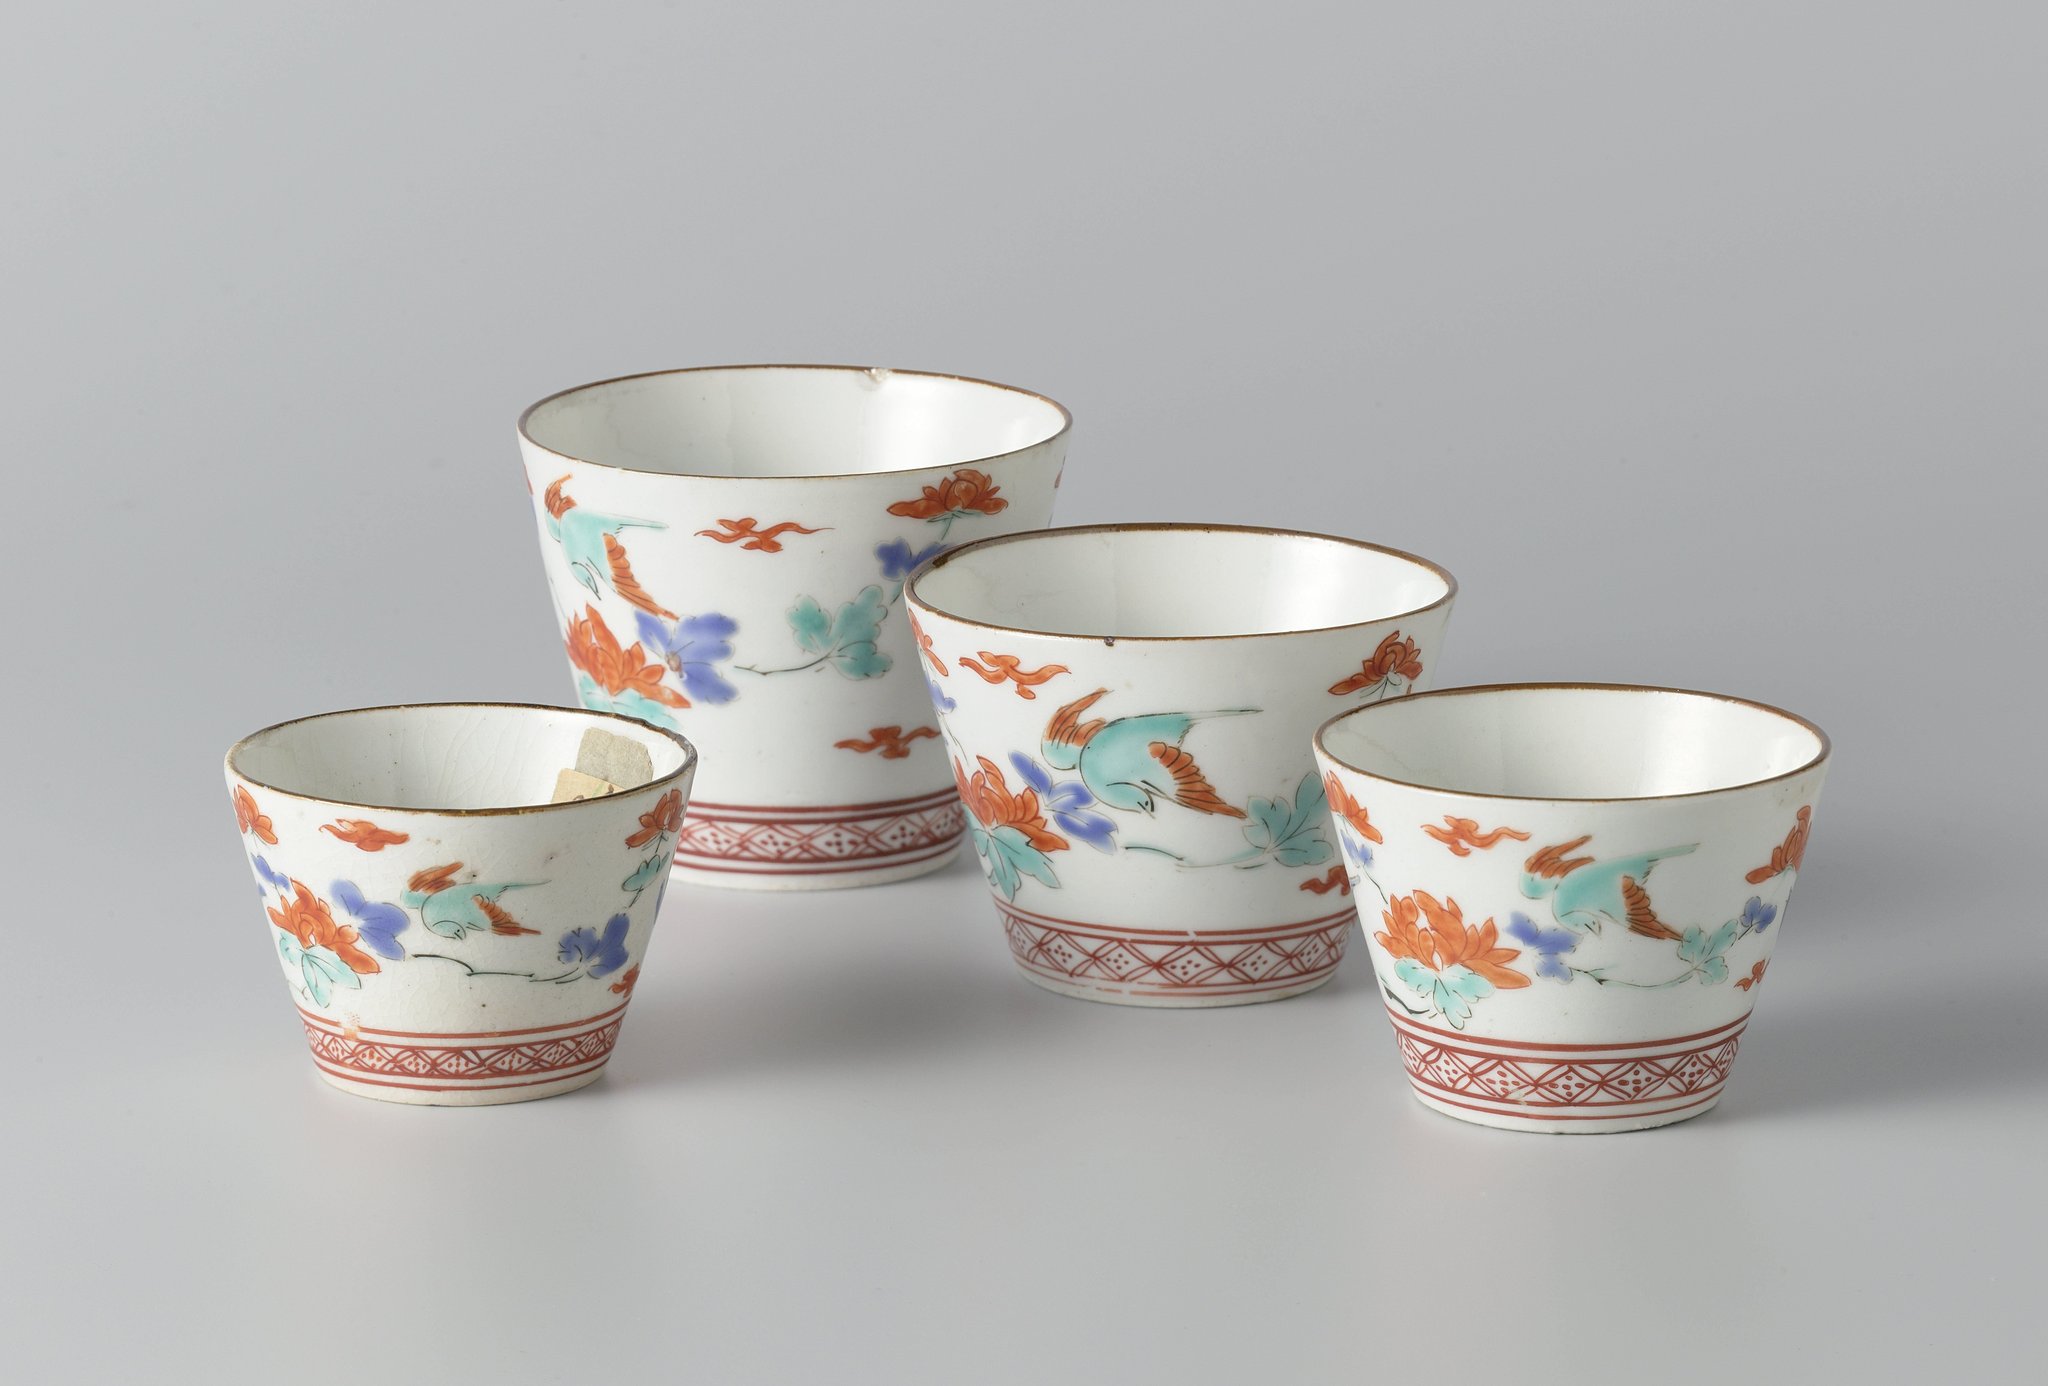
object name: bowl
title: Bowl with birds and flower sprays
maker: Anonymous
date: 1670-1690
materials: glaze, paint, porcelain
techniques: firing, turning, vitrification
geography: arita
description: Japanese porcelain with decoration in the Kakiemon style. Set of four cups c. 1700 - 1725.